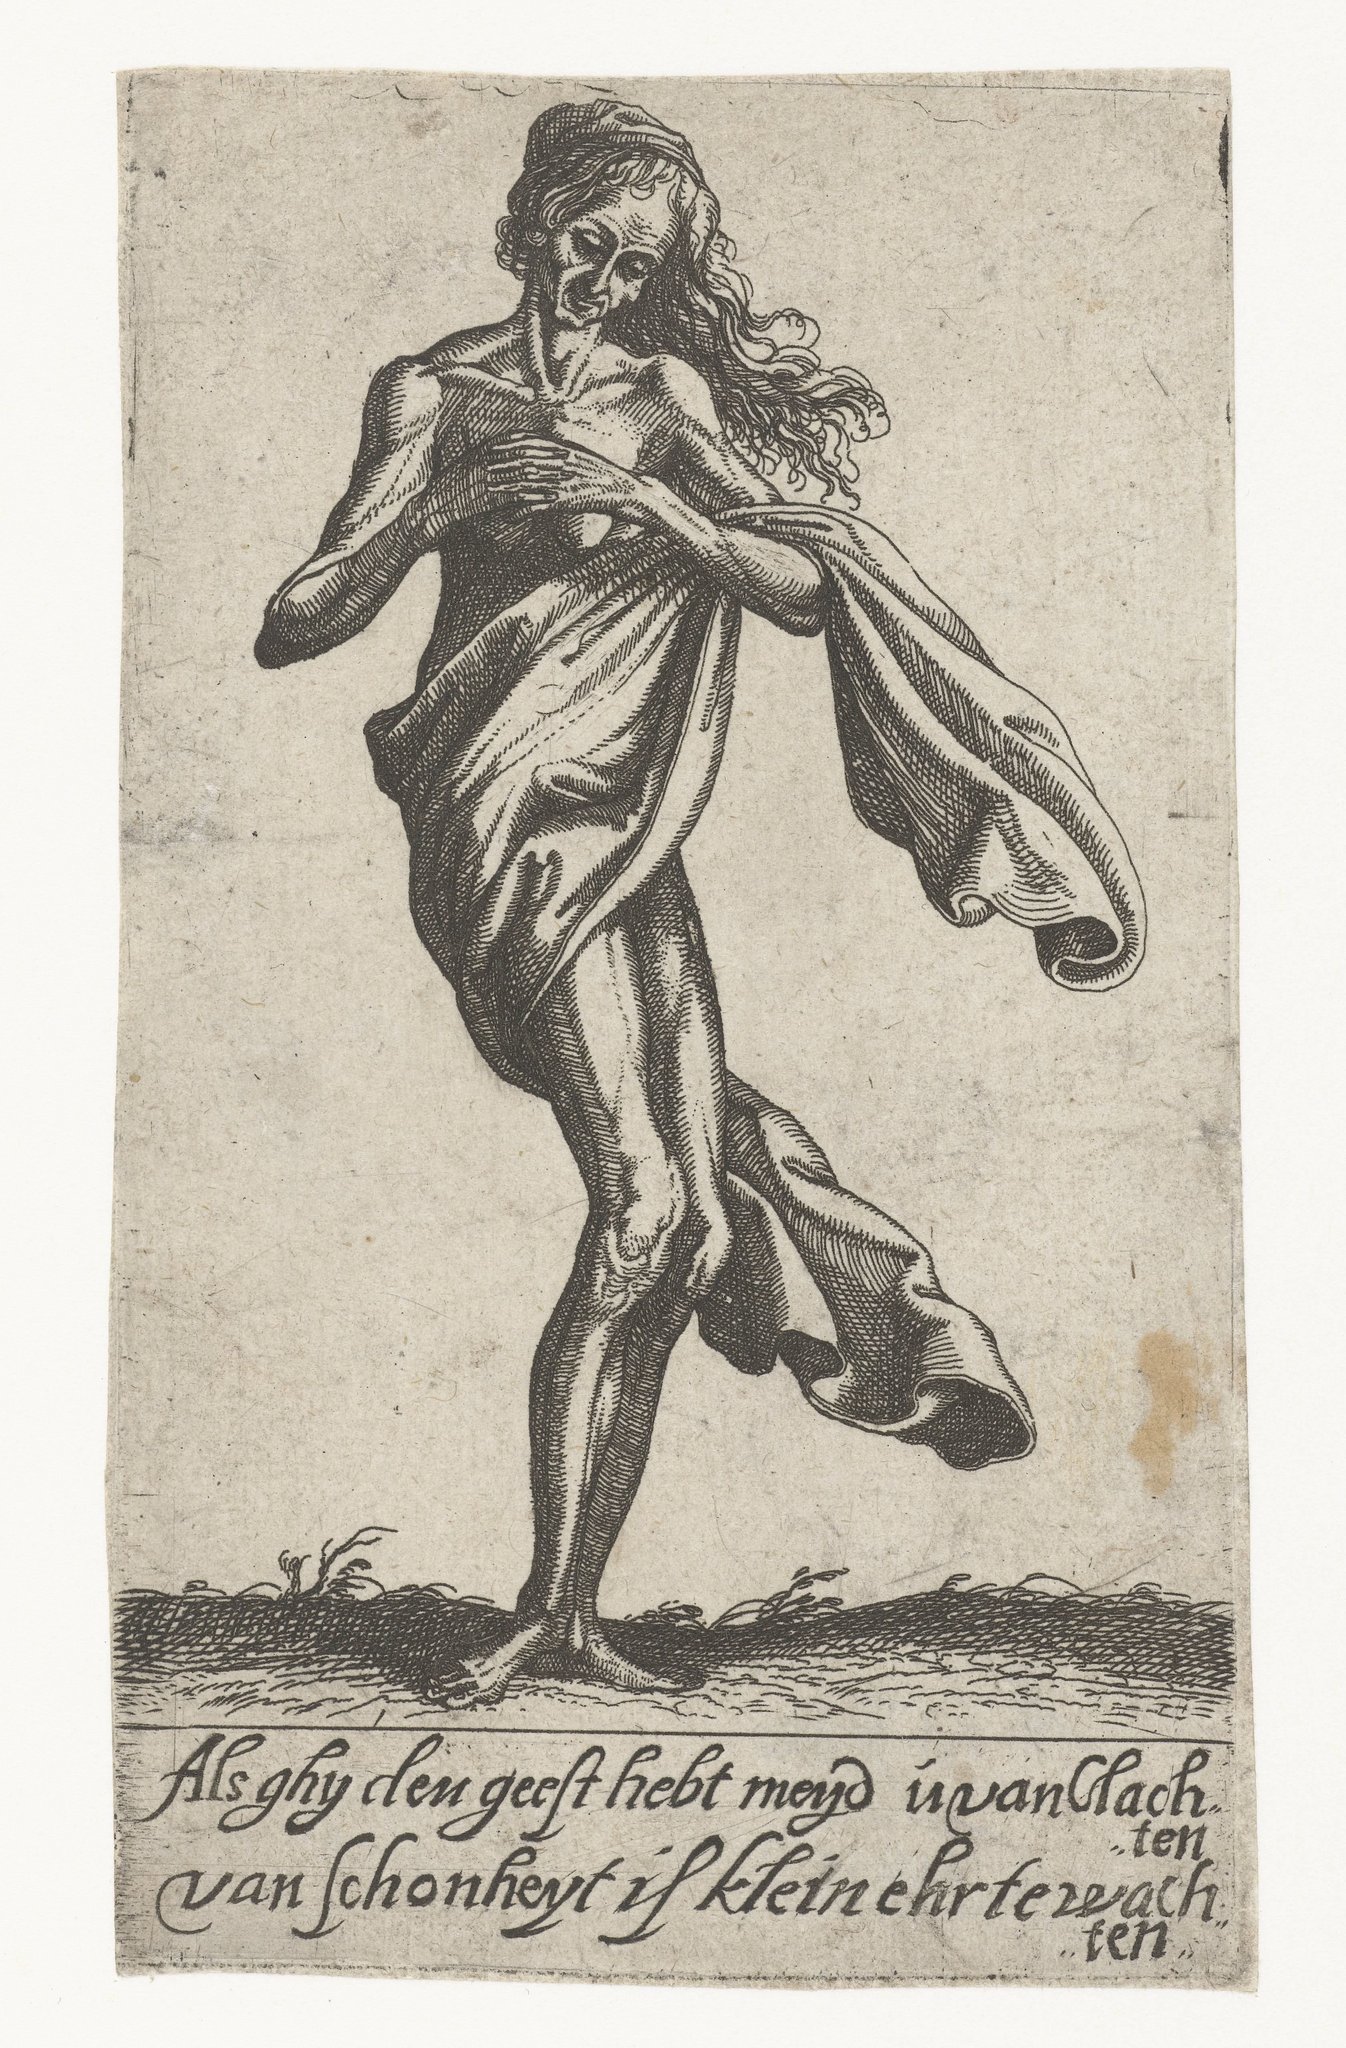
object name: print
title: Staande oude naakte vrouw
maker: claes jansz. visscher (ii)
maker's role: draughtsman, print maker, publisher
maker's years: 1586-1652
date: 1615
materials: paper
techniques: etching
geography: amsterdam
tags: the (nude) human figure; 'corpo humano' (ripa) (+ old female (human being)), ugly old woman, hag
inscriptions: collector's mark: Lugt 2228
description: Staande oude naakte vrouw ten voeten uit, om haar middel een doek. In de ondermarge een tweeregelig onderschrift in het Nederlands.